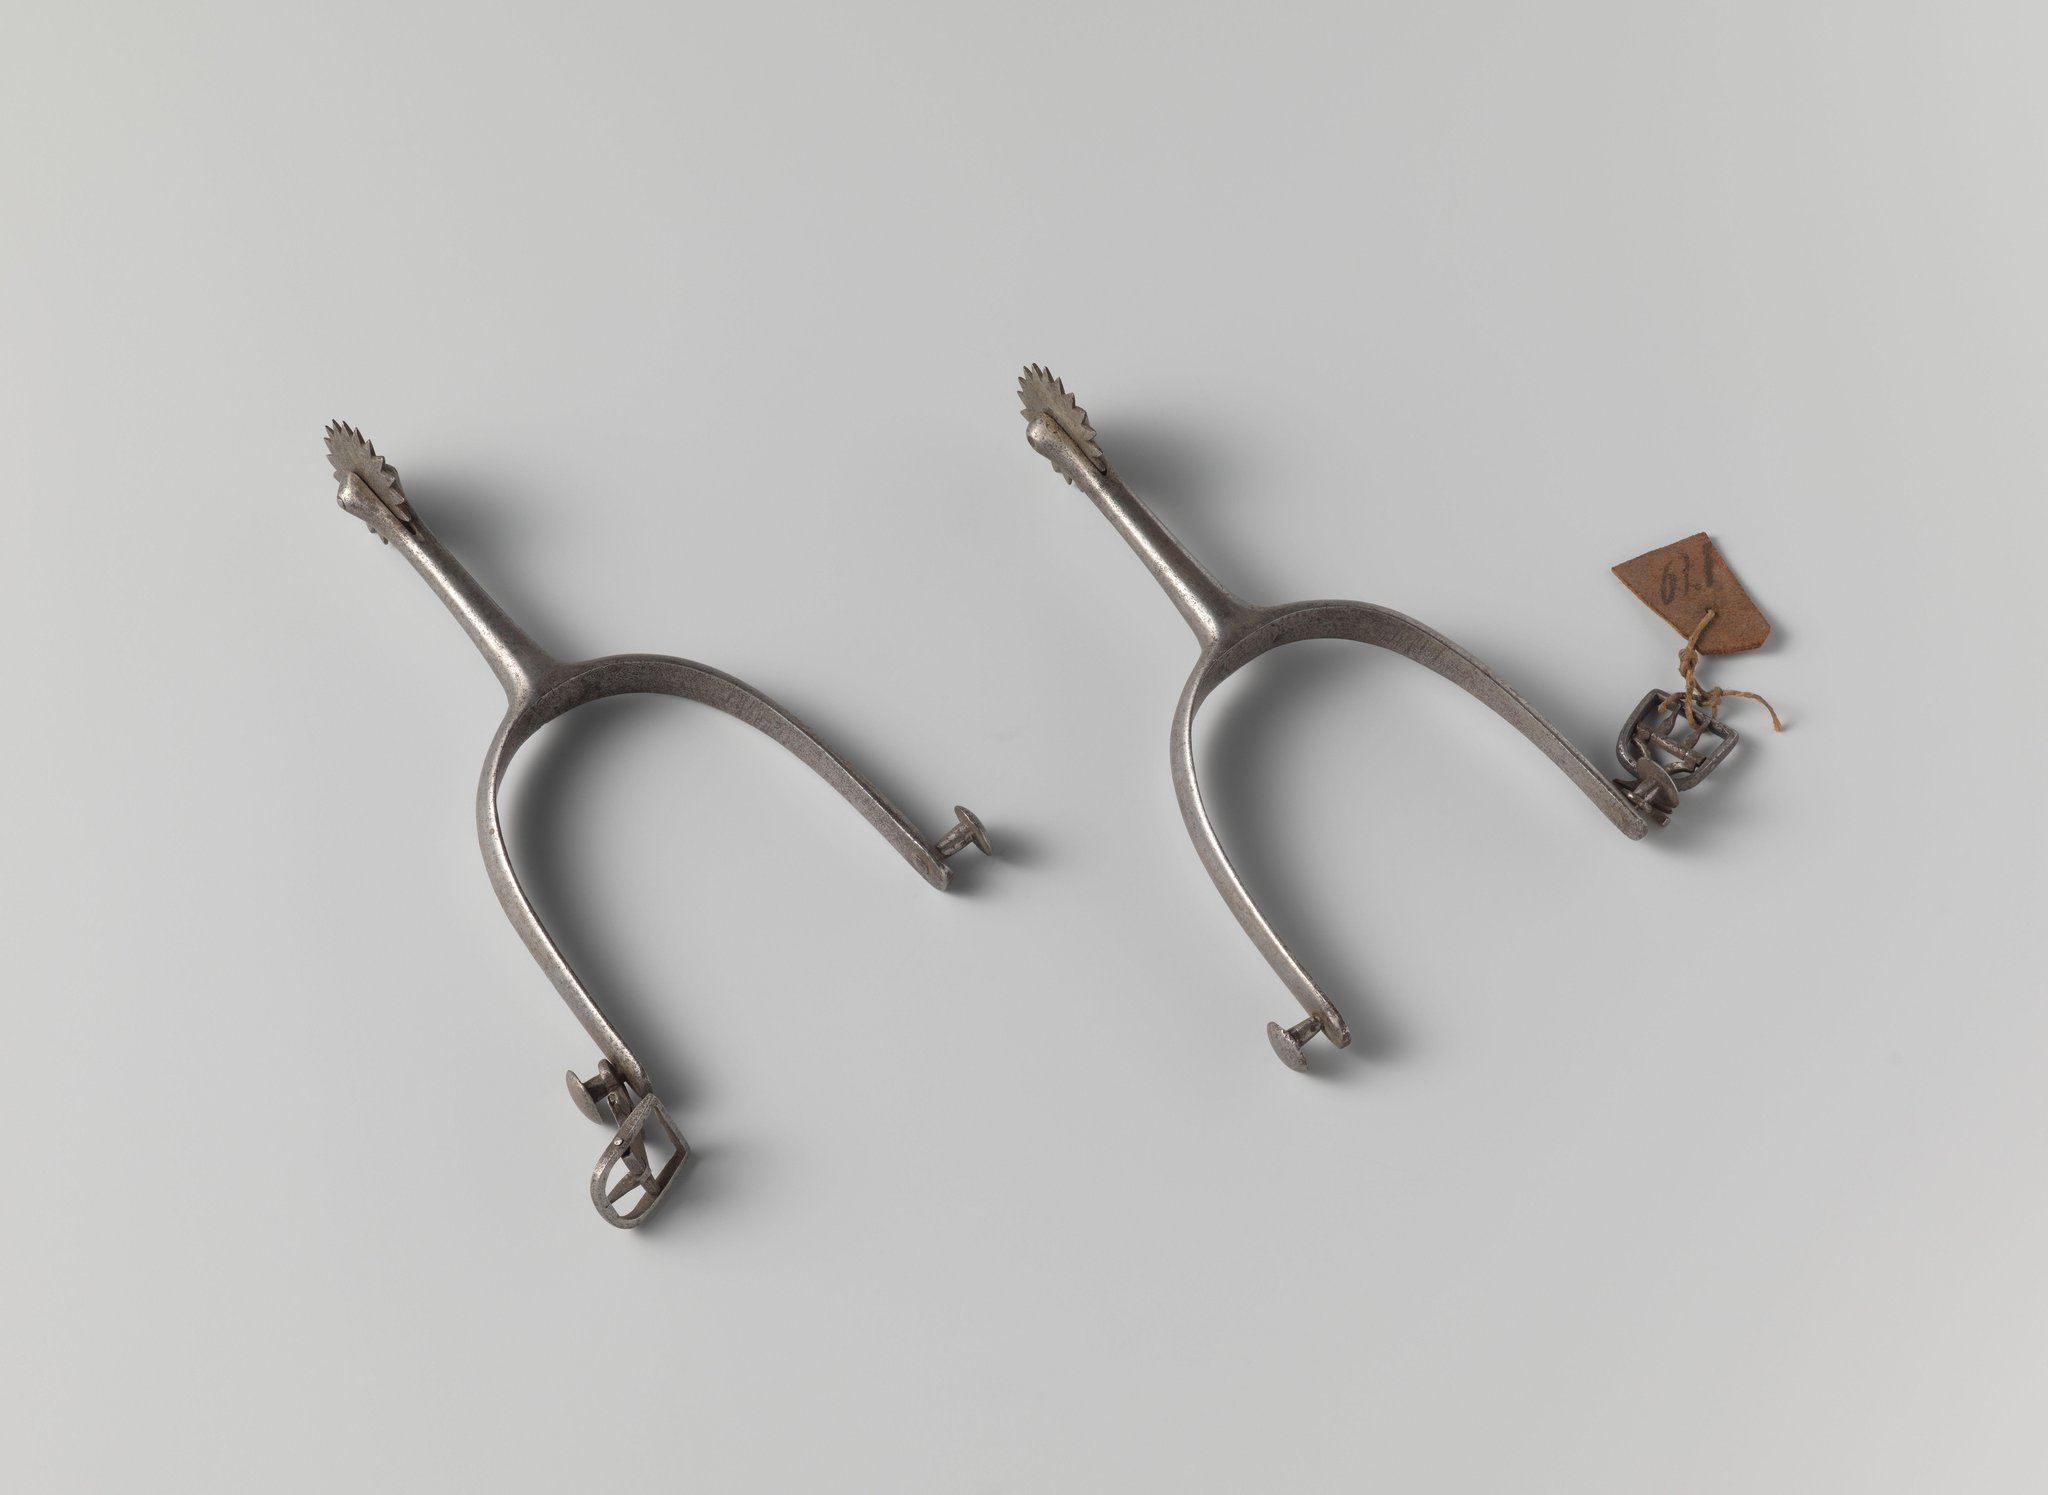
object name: spur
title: Spoor van staal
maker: Anonymous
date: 1825-1832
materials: steel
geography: netherlands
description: Stalen spoor met gesp, rechte hals met groot getand wiel.